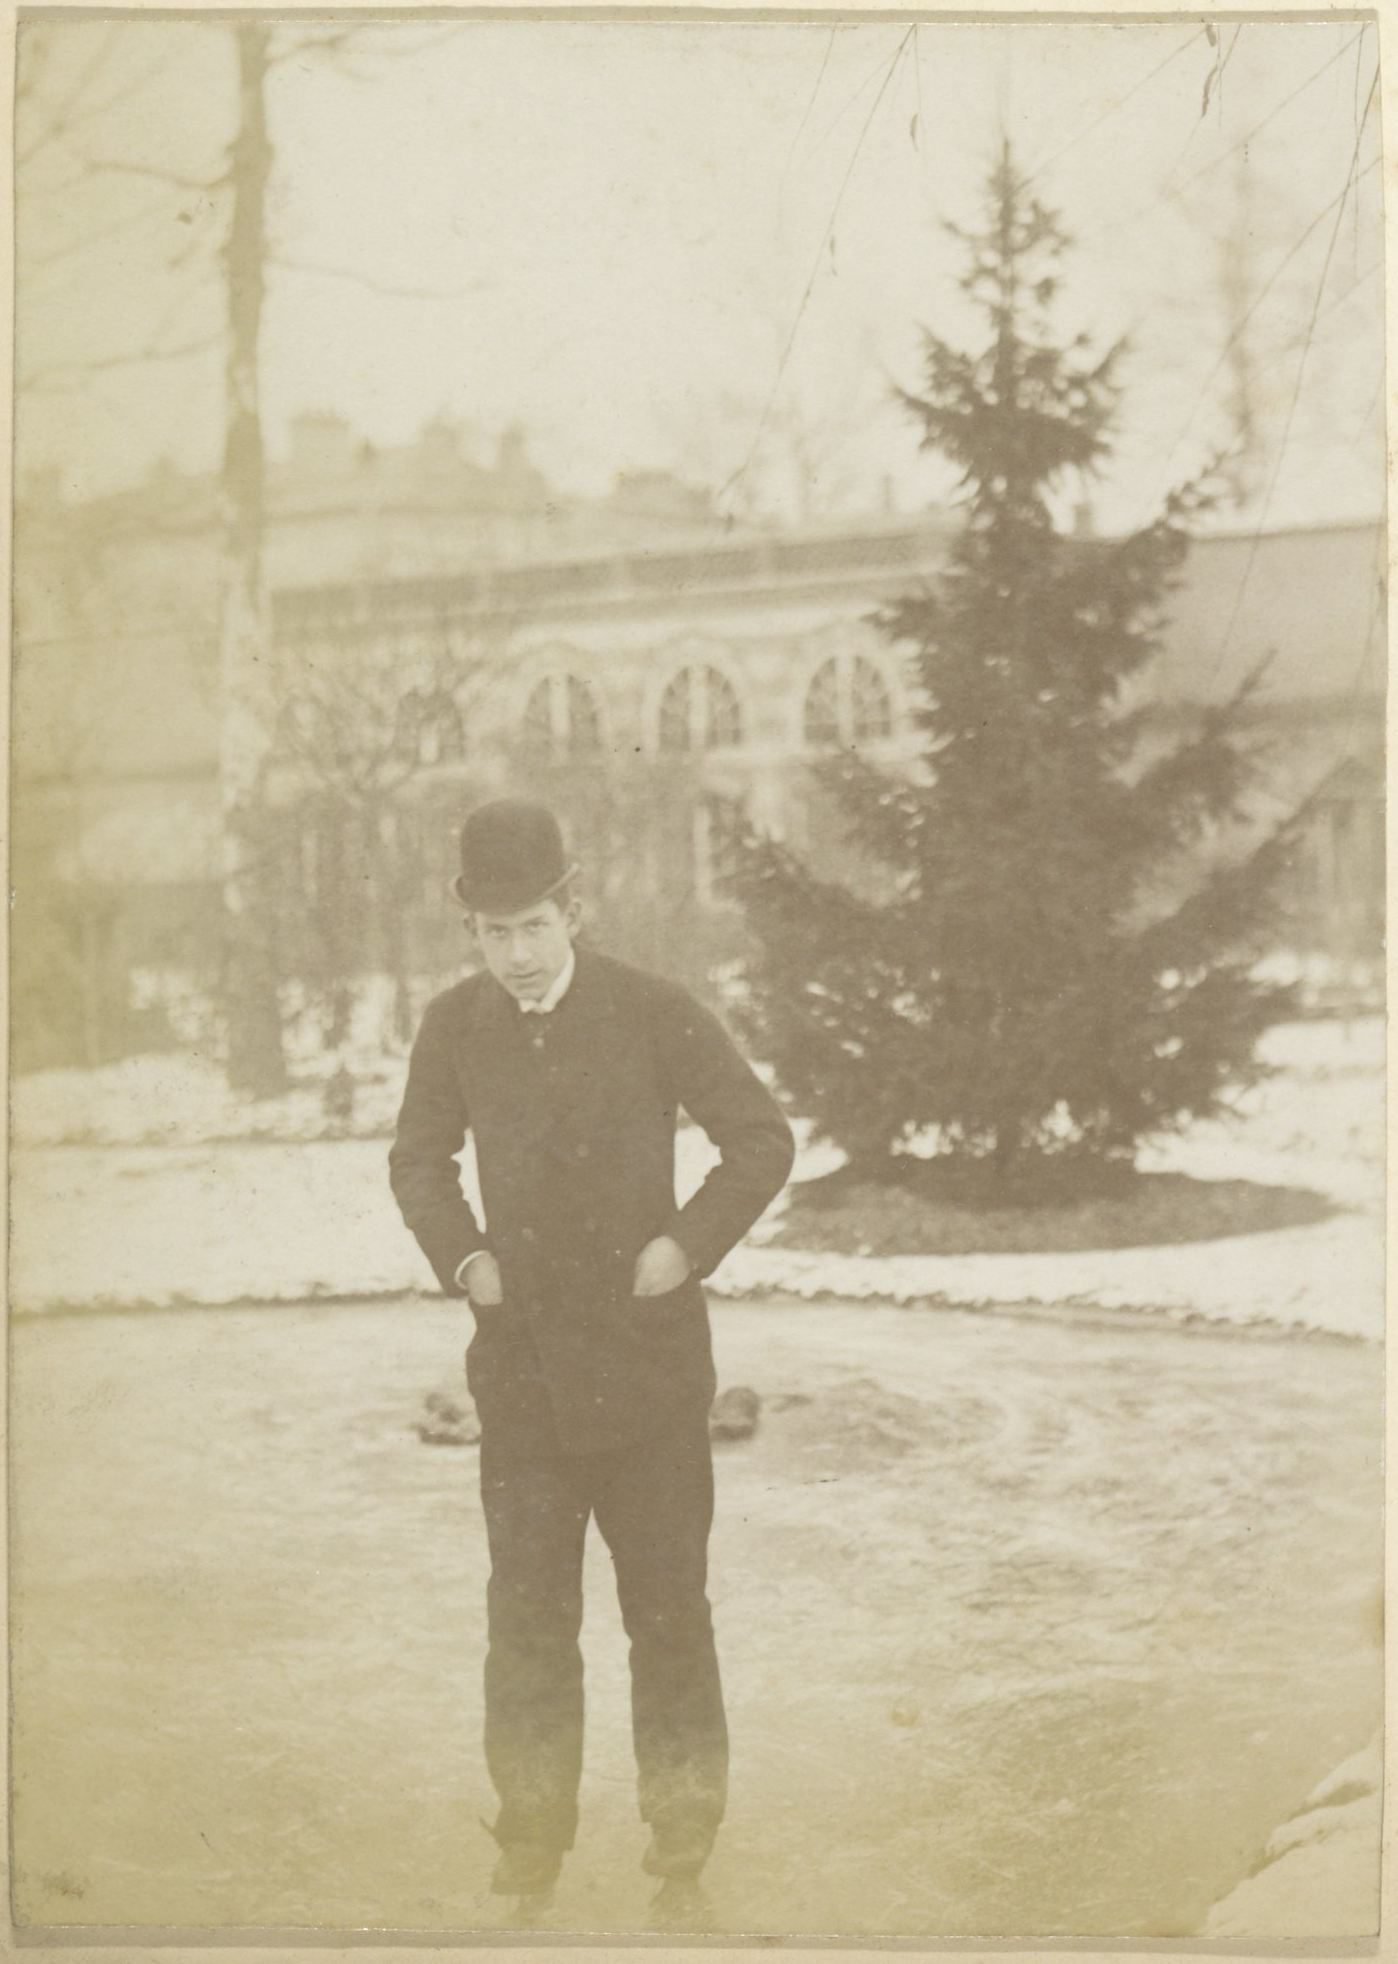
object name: photograph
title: Man met een bolhoed schaatsend op een vijver bij een villa in Frankrijk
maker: Anonymous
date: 1900-1910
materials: paper, photographic support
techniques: albumen print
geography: france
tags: hand in the pocket - aa - both arms or hands, head-gear: bowler hat, adult man, skates (winter sports), trees: fir, france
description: Onderdeel van Fotoalbum van een Franse amateurfotograaf met opnames van een familie, distilleerderij Delizy & Doistau Fils, het leger en bezienswaardigheden in Frankrijk.